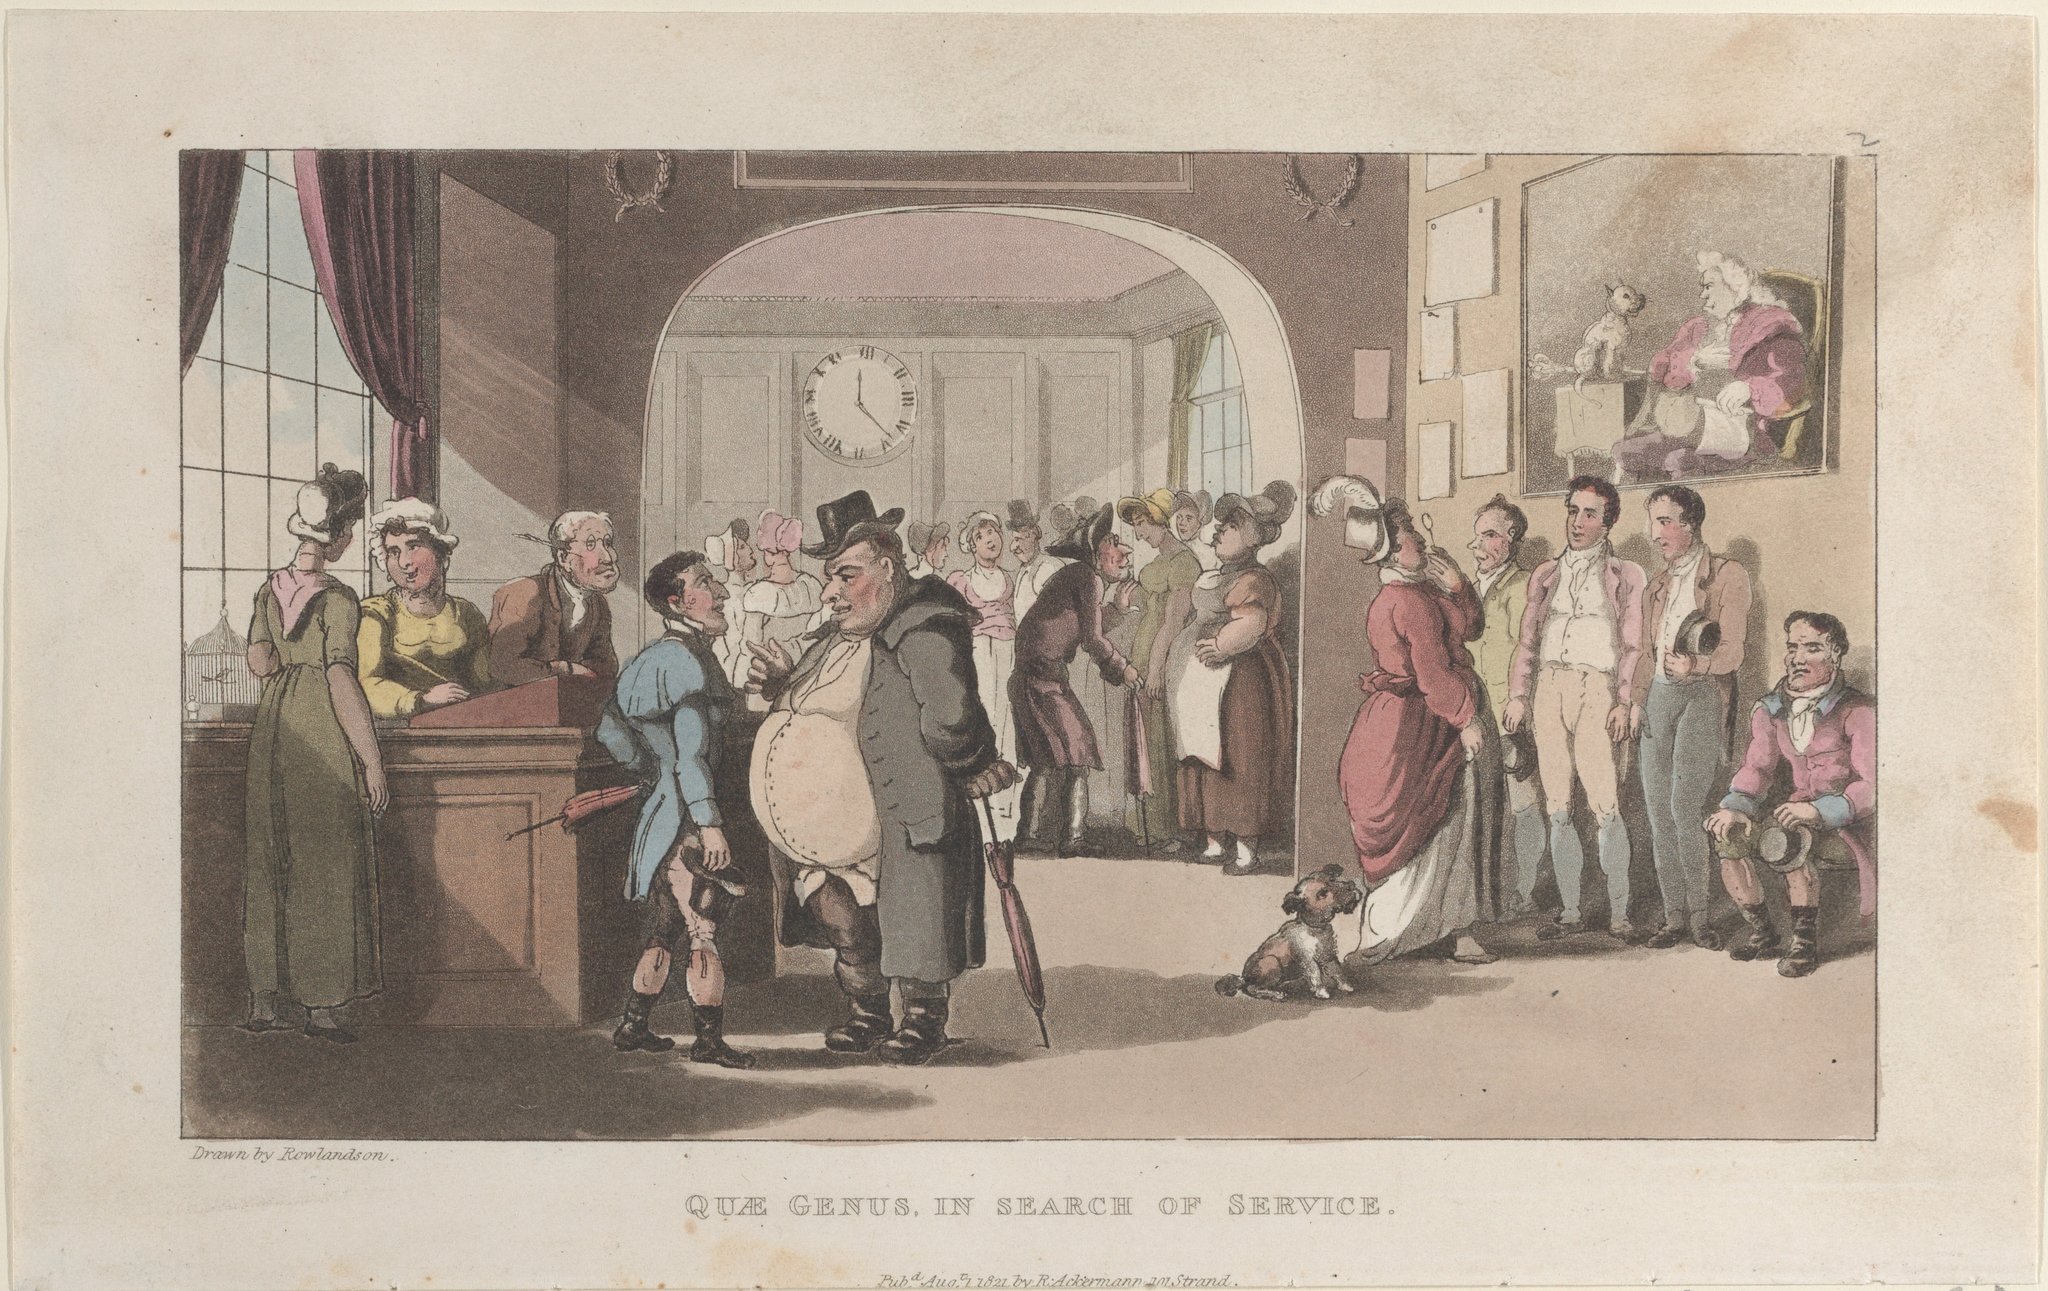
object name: print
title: Quae Genus in Search of Service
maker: thomas rowlandson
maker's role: artist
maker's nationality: british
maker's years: 1757-1827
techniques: aquatint, etching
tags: men,women